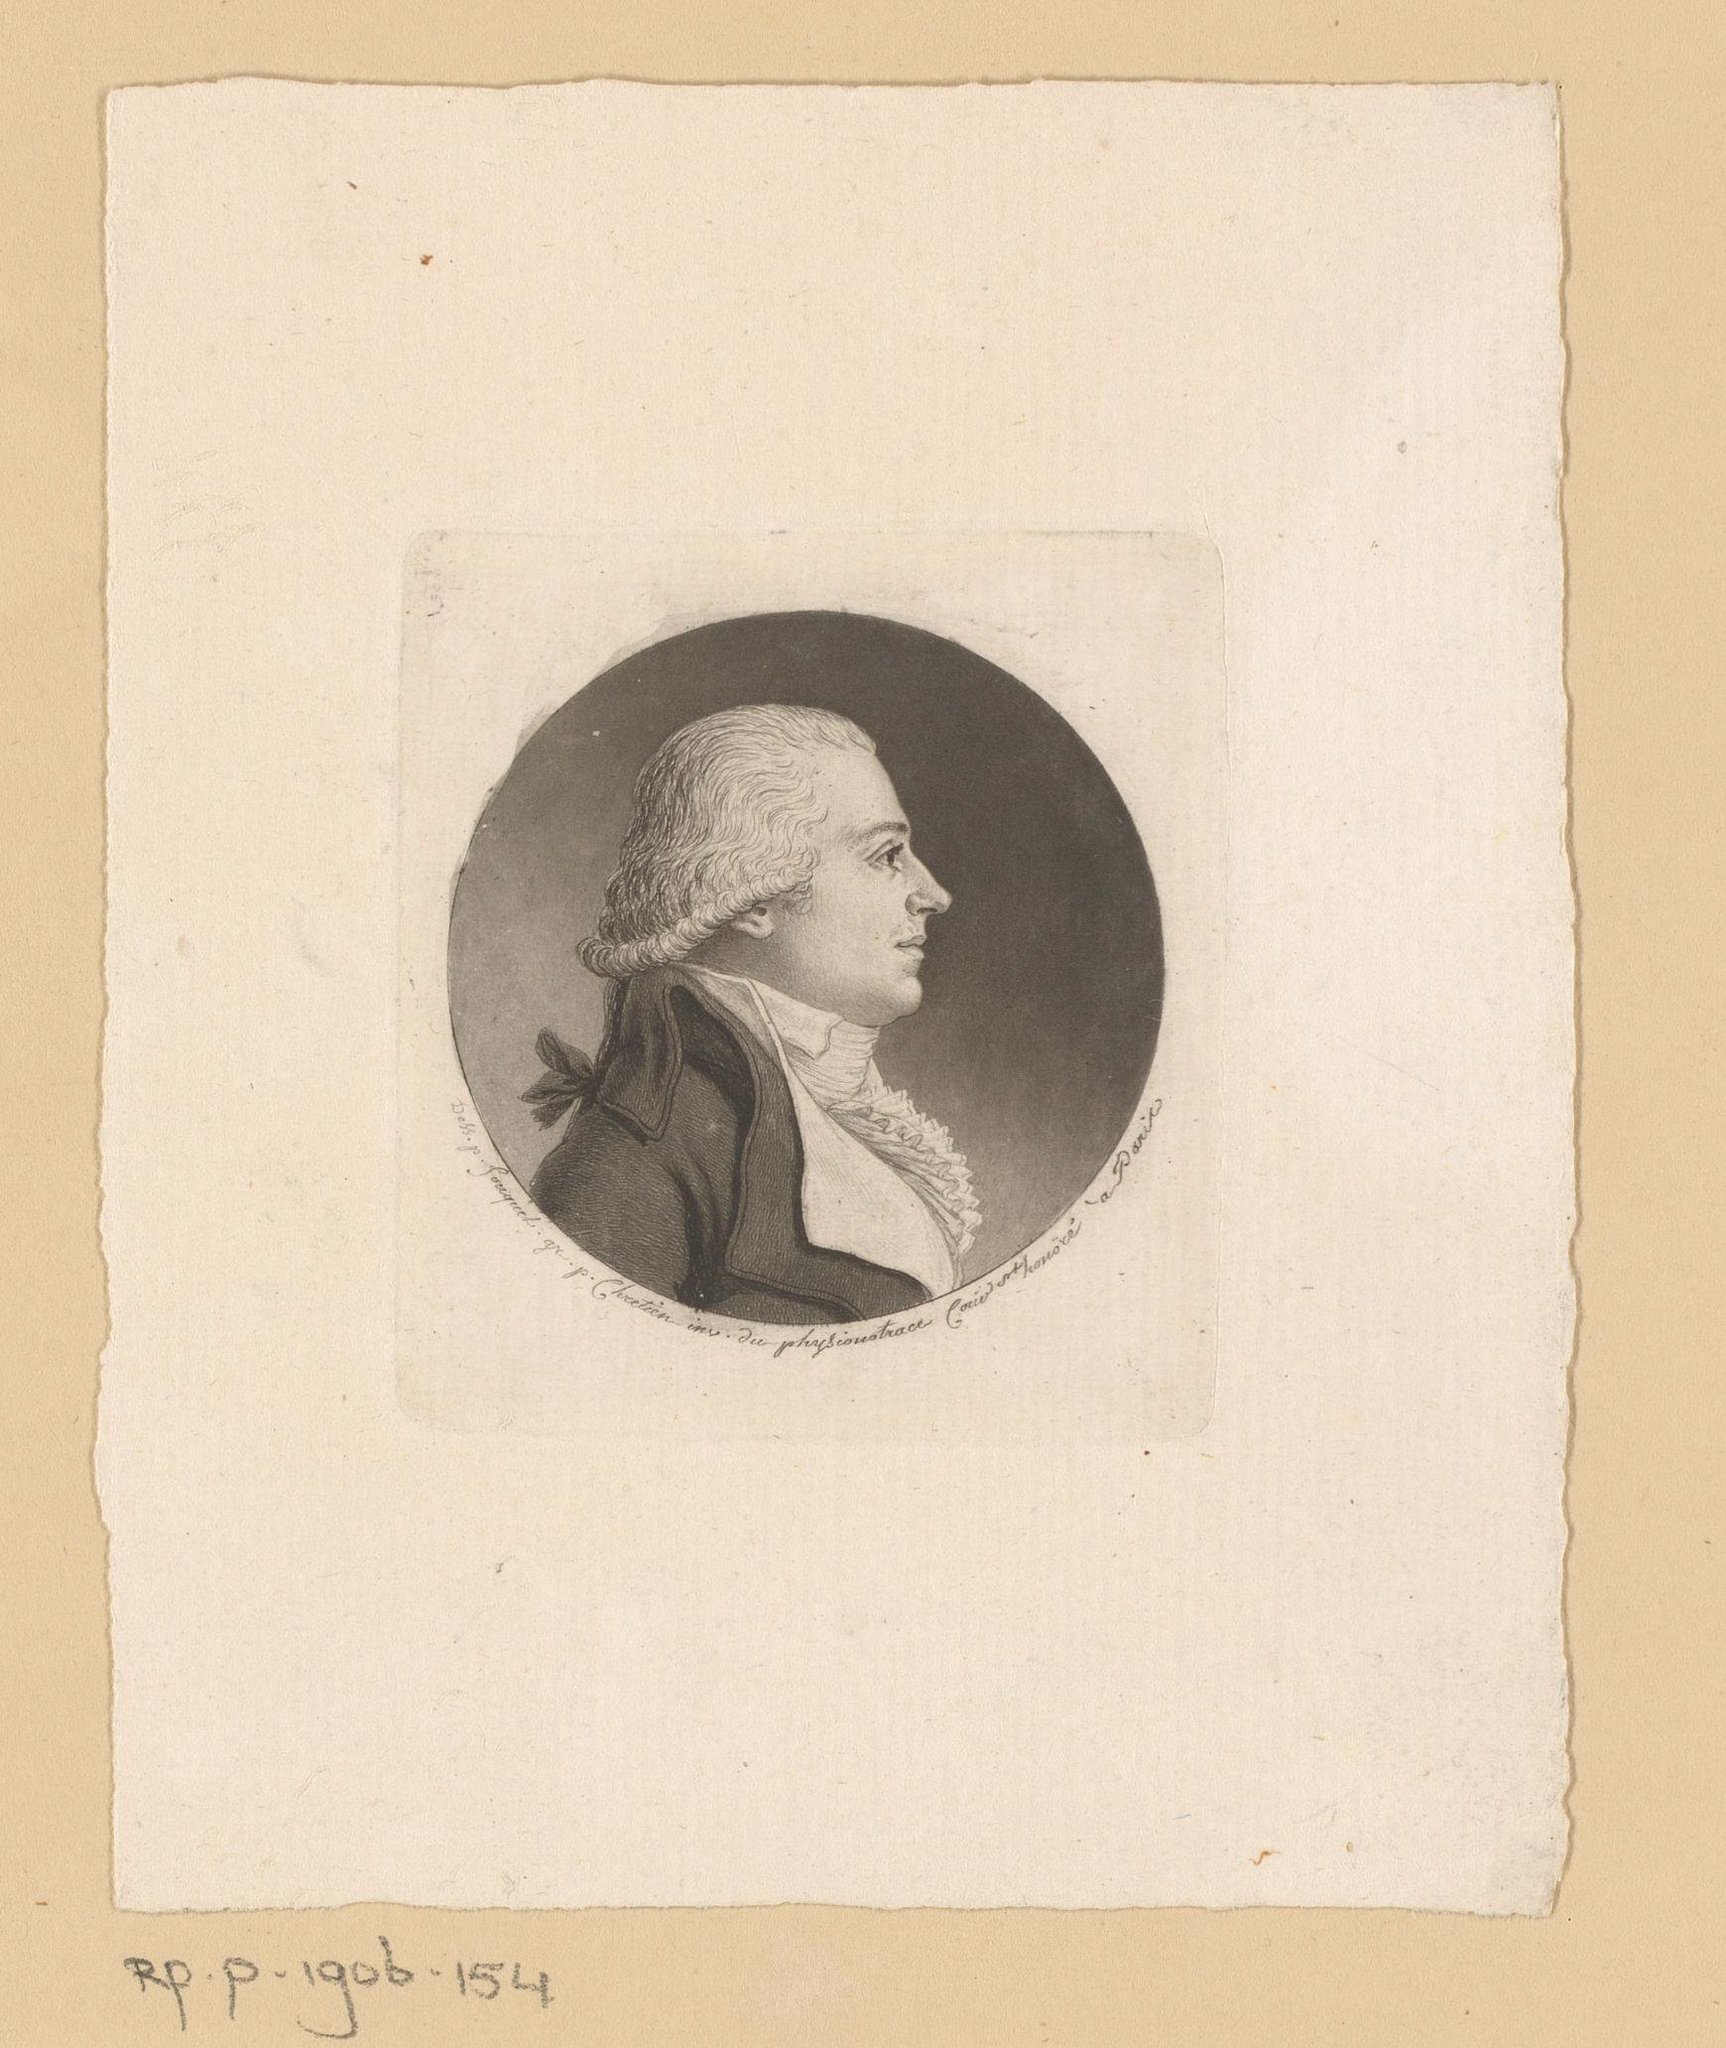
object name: print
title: Portret van Jan David Pasteur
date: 1785-1811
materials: paper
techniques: aquatint, etching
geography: paris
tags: leiden, jan david pasteur, silhouette-apparatus, 'physionotrace', historical persons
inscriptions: collector's mark: Lugt 2228